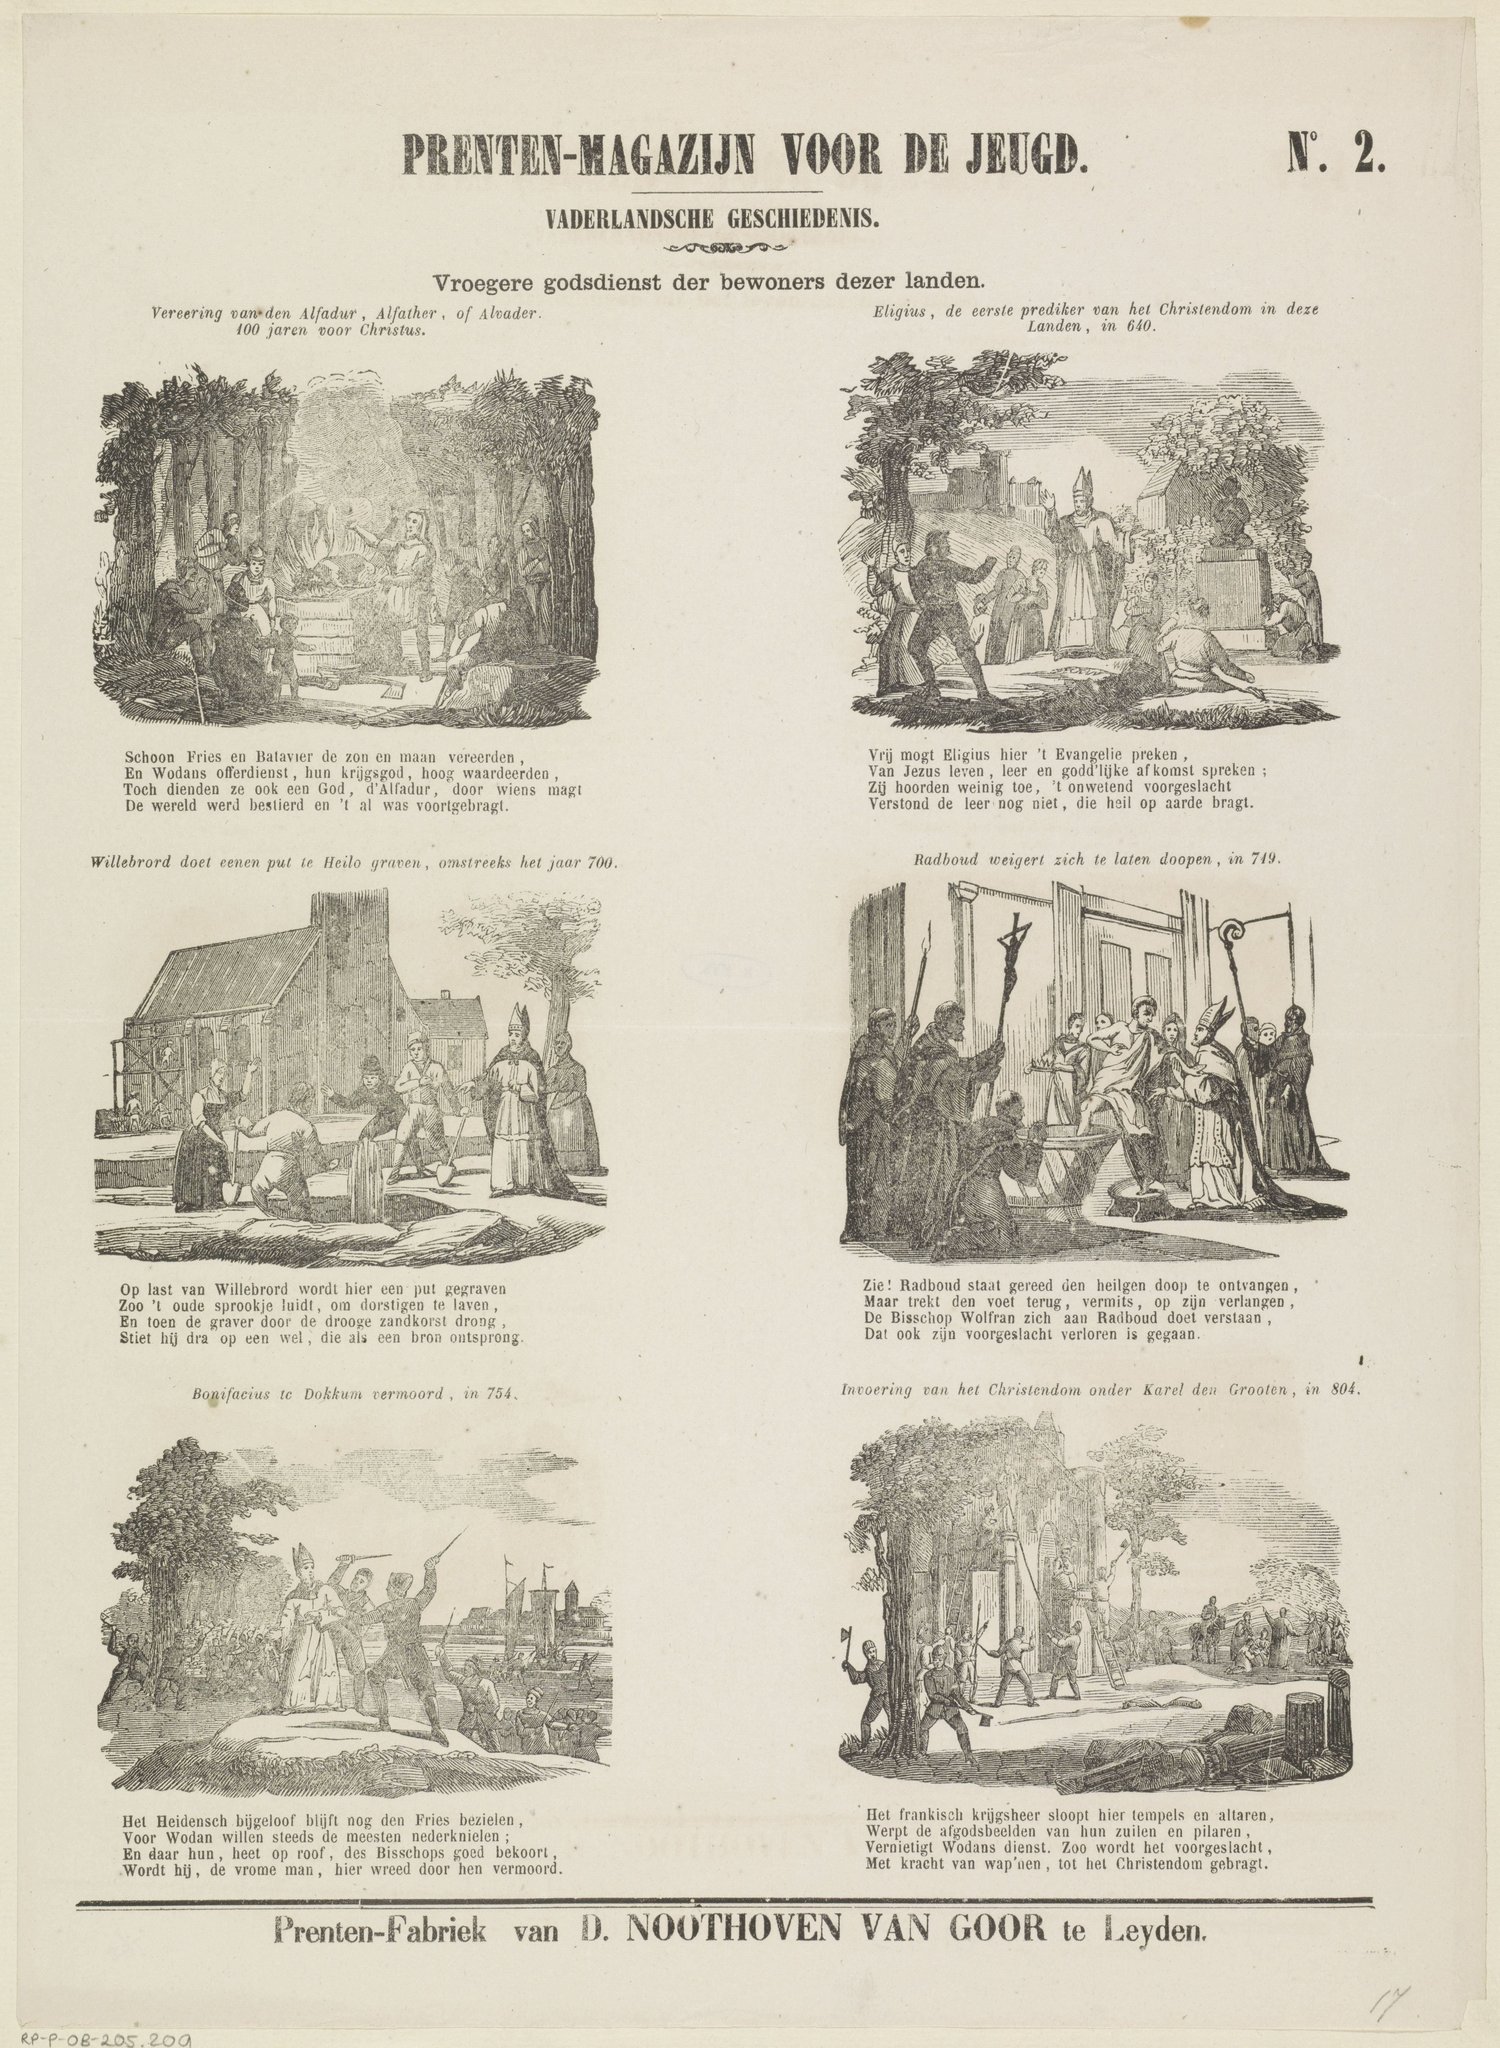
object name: print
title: Vroegere godsdienst der bewoners dezer landen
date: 1850-1881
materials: paper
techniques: letterpress printing, engraving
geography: leiden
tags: charlemagne (holy roman emperor), bishop st. eloi preaching, martyr(s) (often with palm-branches)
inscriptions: collector's mark: Lugt 2228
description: Blad met 6 voorstellingen van gebeurtenissen uit de vaderlandse geschiedenis, met betrekking tot het Christendom. Boven elke voorstelling een titel en een jaartal, onder elke voorstelling een vierregelig vers. Genummerd rechtsboven: No. 2.